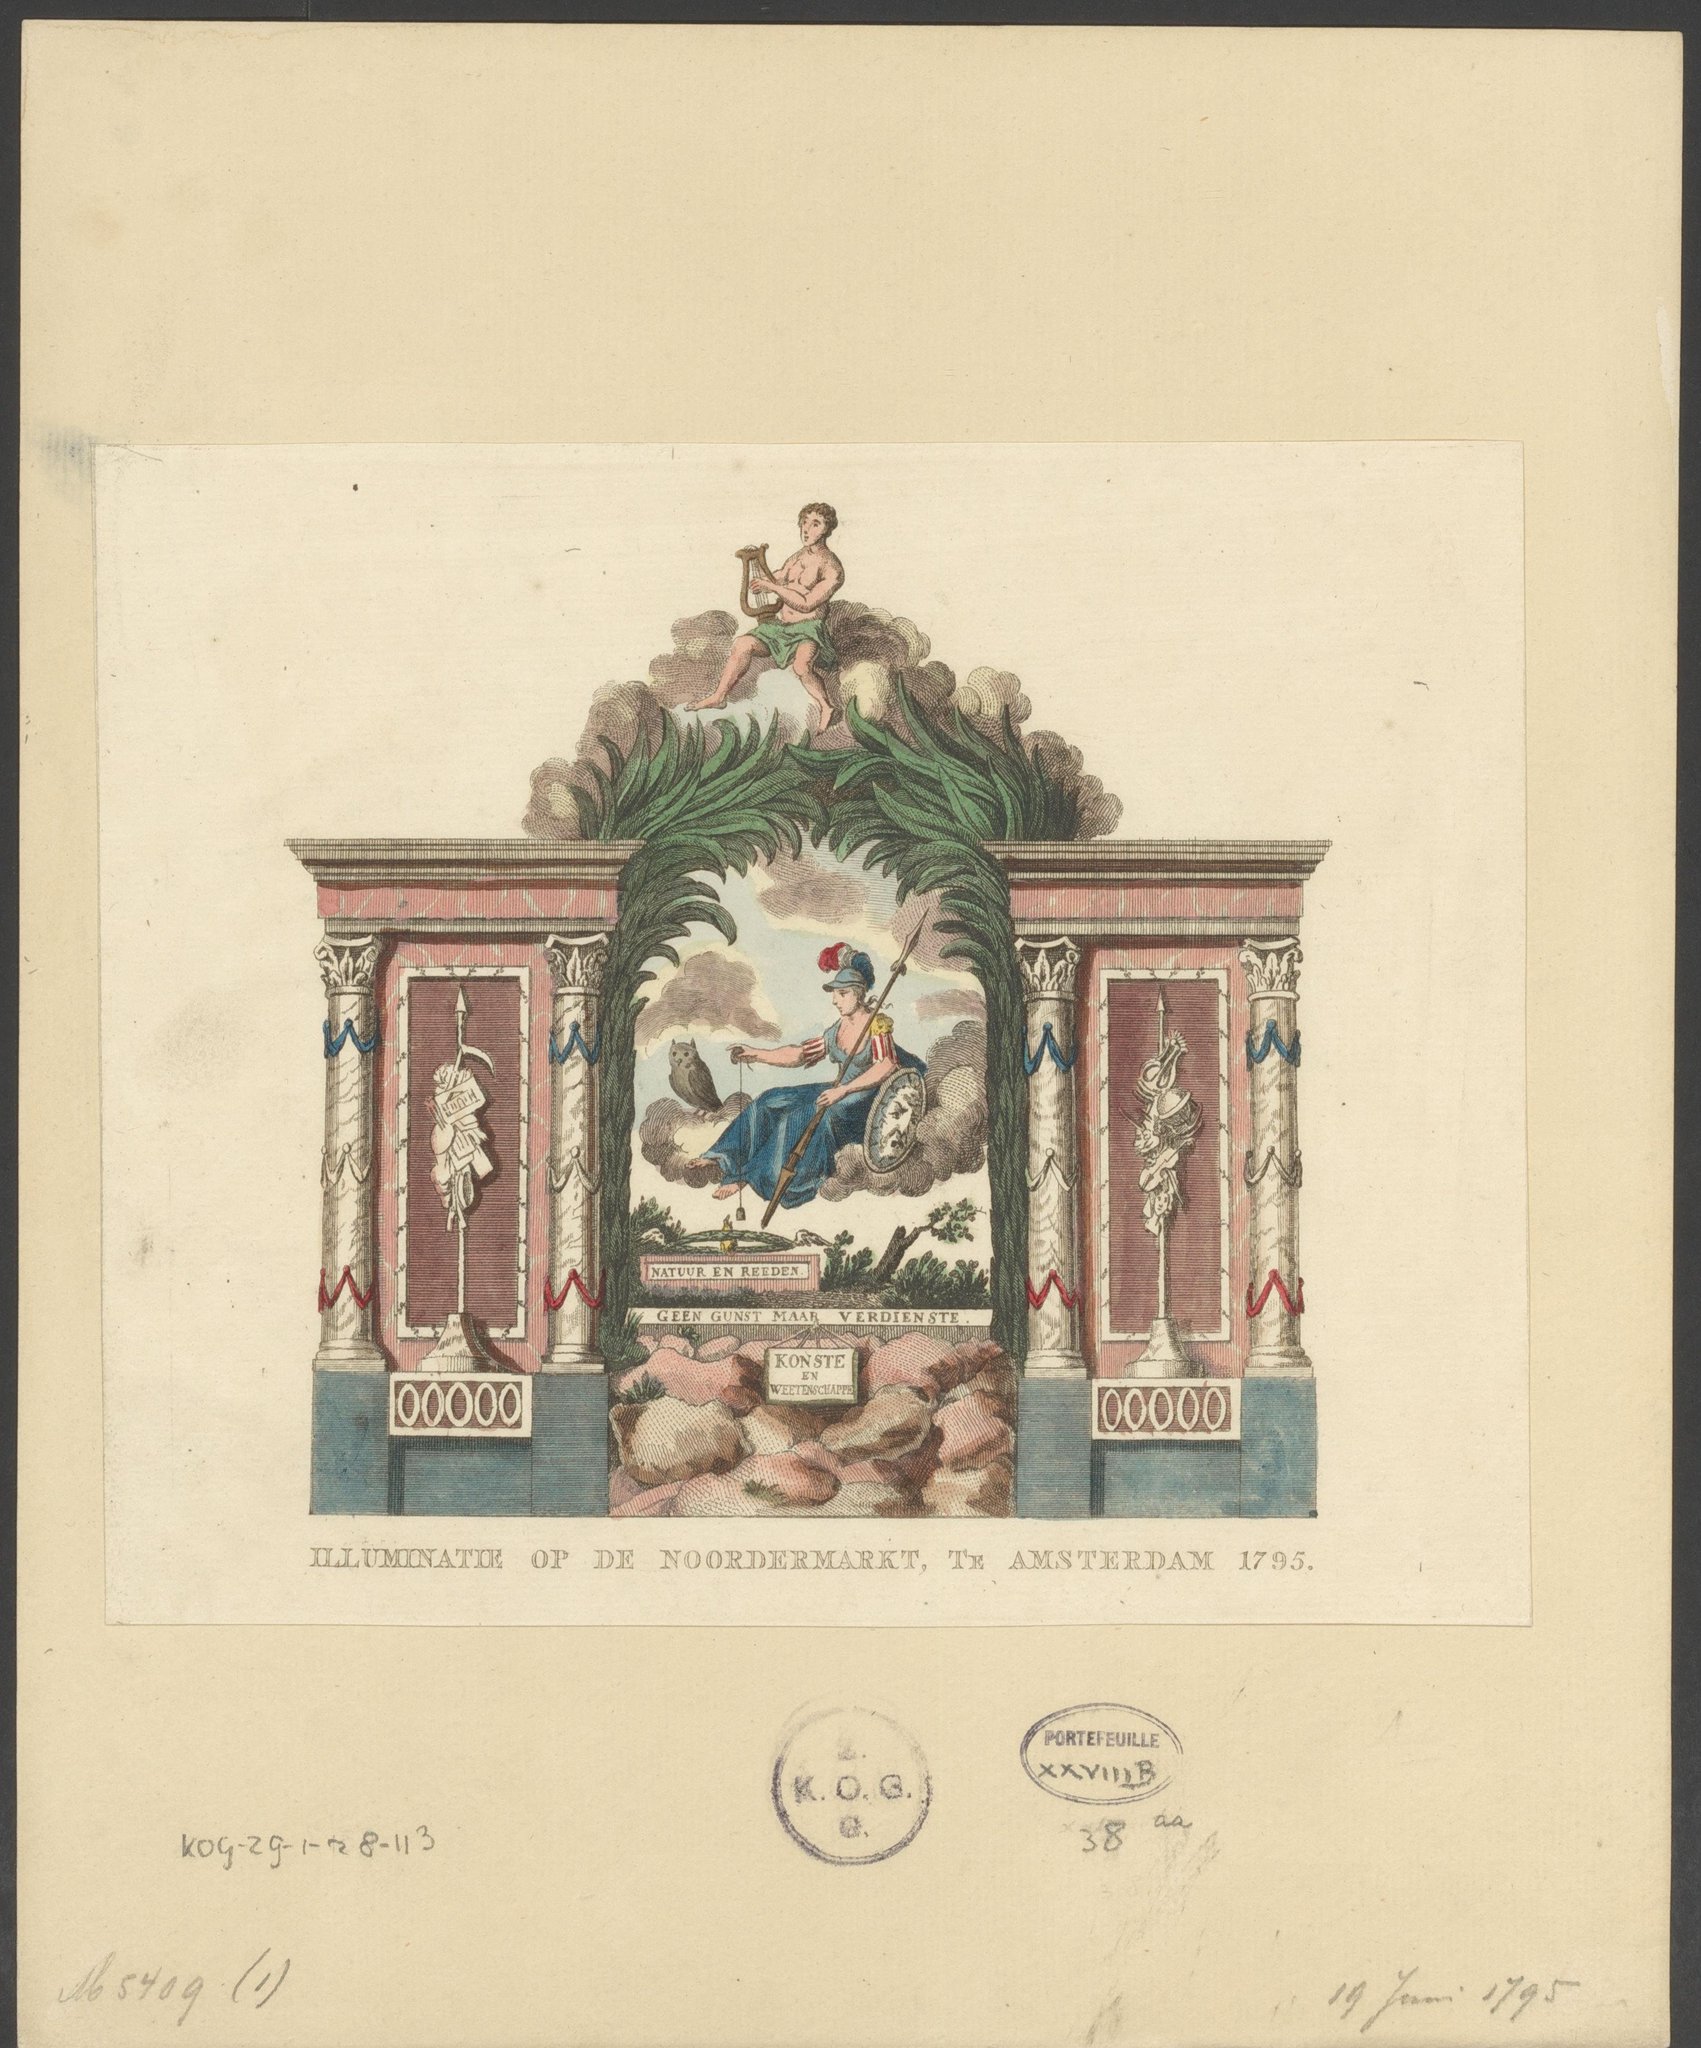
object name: print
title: Kunsten en Wetenschappen, decoratie op de Noordermarkt, 1795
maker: a. schol (ii)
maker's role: print maker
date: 1795-1797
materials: paper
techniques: etching, hand coloring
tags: festivities on events of national importance, specific aspects, allegorical aspects of minerva; minerva as patroness, equality, equity, fairness, righteousness; 'equalità', 'equità', 'giuditio giusto', 'ordine dritto e giusto', 'ugualità' (ripa), amsterdam, alliance with france (1795)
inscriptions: collector's mark: Lugt 1641, stamp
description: Kunsten en Wetenschappen, allegorische decoratie opgericht op de Noordermarkt te Amsterdam bij het Alliantiefeest op 19 juni 1795. Minerva zittend in de wolken met schietlood (Gelijkheid) boven een krans en vuur. Bovenaan Apollo spelend op de lier. Onderdeel van een serie van dertien platen. Onderwerpsrubrieken binnen de Atlas Zeden en Gewoonten: Zeden en Gewoonten in Engeren Zin. Volksleven. Openbare feesten. Vorstelijke intochten, (Illuminaties, vuurwerken en dergelijke, openbare feesten).